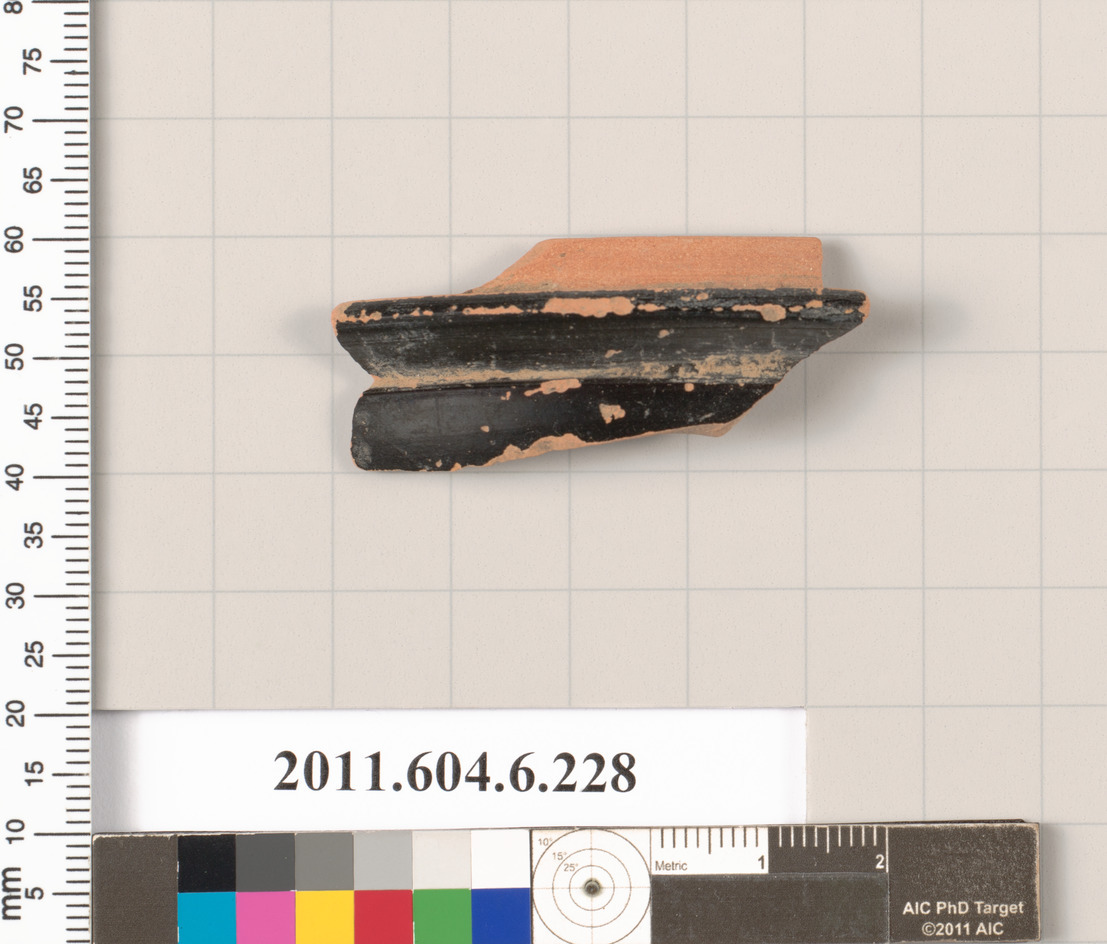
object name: pyxis fragment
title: Terracotta fragment of a pyxis (box)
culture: greek, attic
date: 500-401 BCE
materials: terracotta